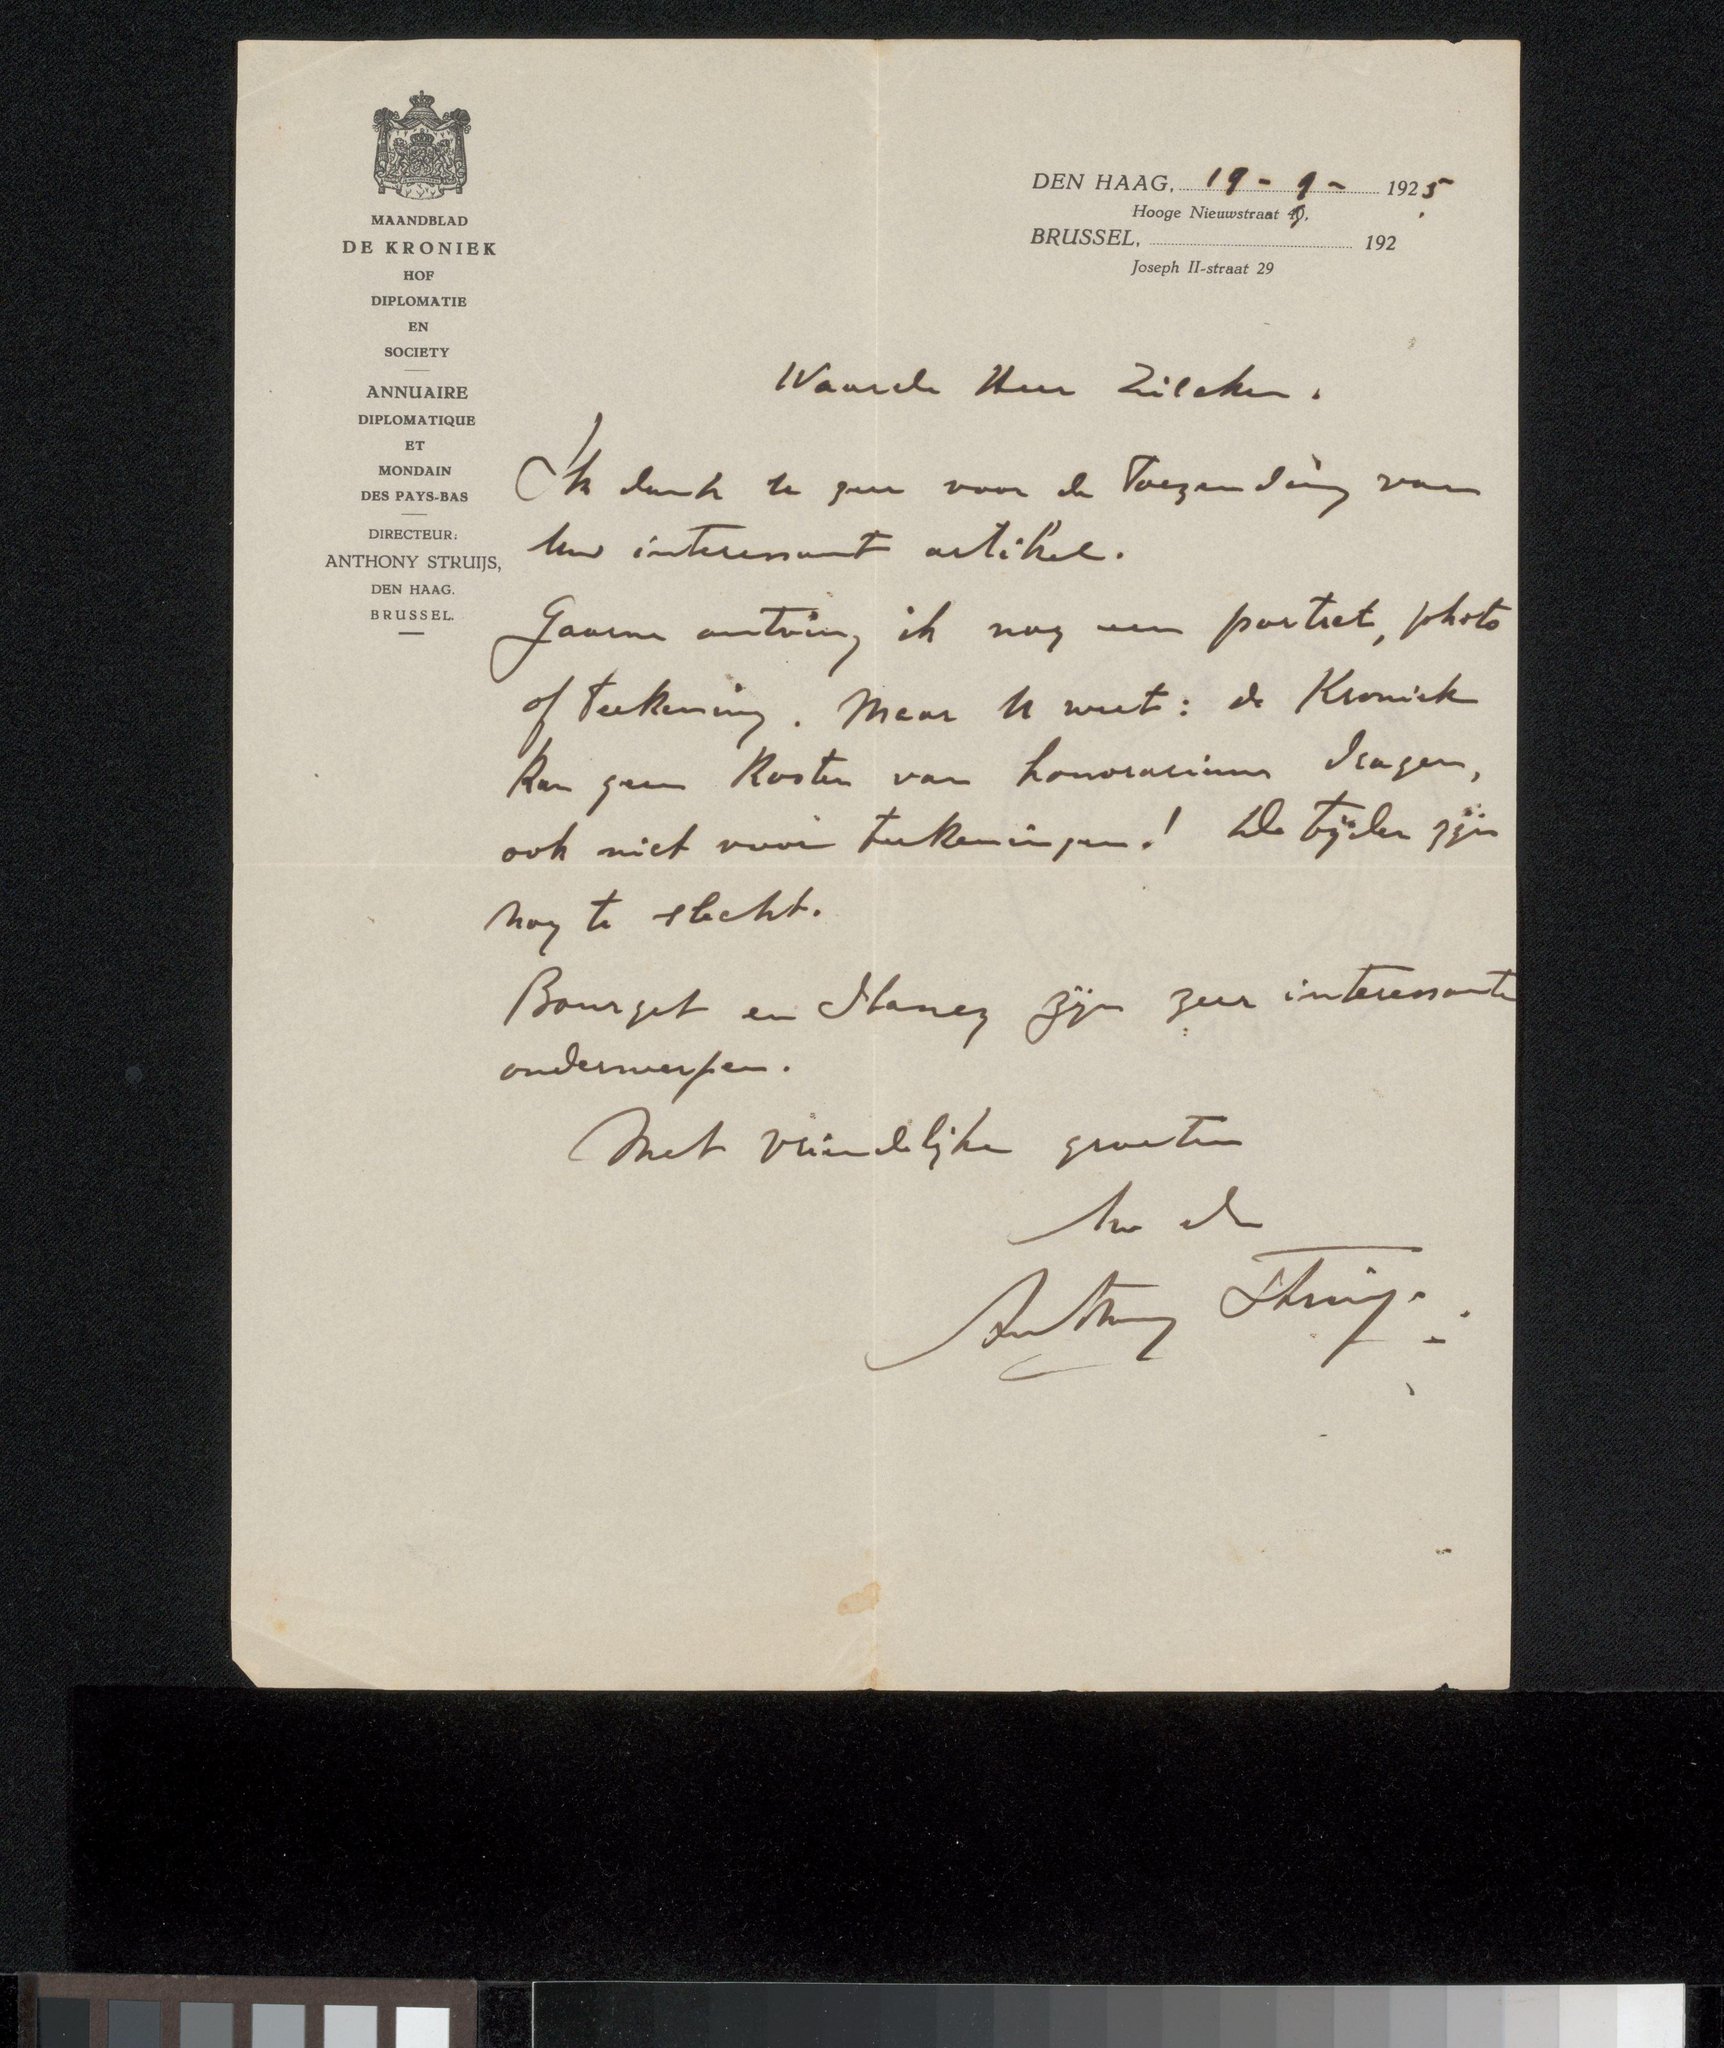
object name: letter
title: Brief aan Philip Zilcken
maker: anthony struys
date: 1925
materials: ink, paper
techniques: pen, printing, writing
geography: the hague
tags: camille bourget, the hague, painter, draughtsman, philip zilcken, money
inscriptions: collector's mark: ‘RPK’